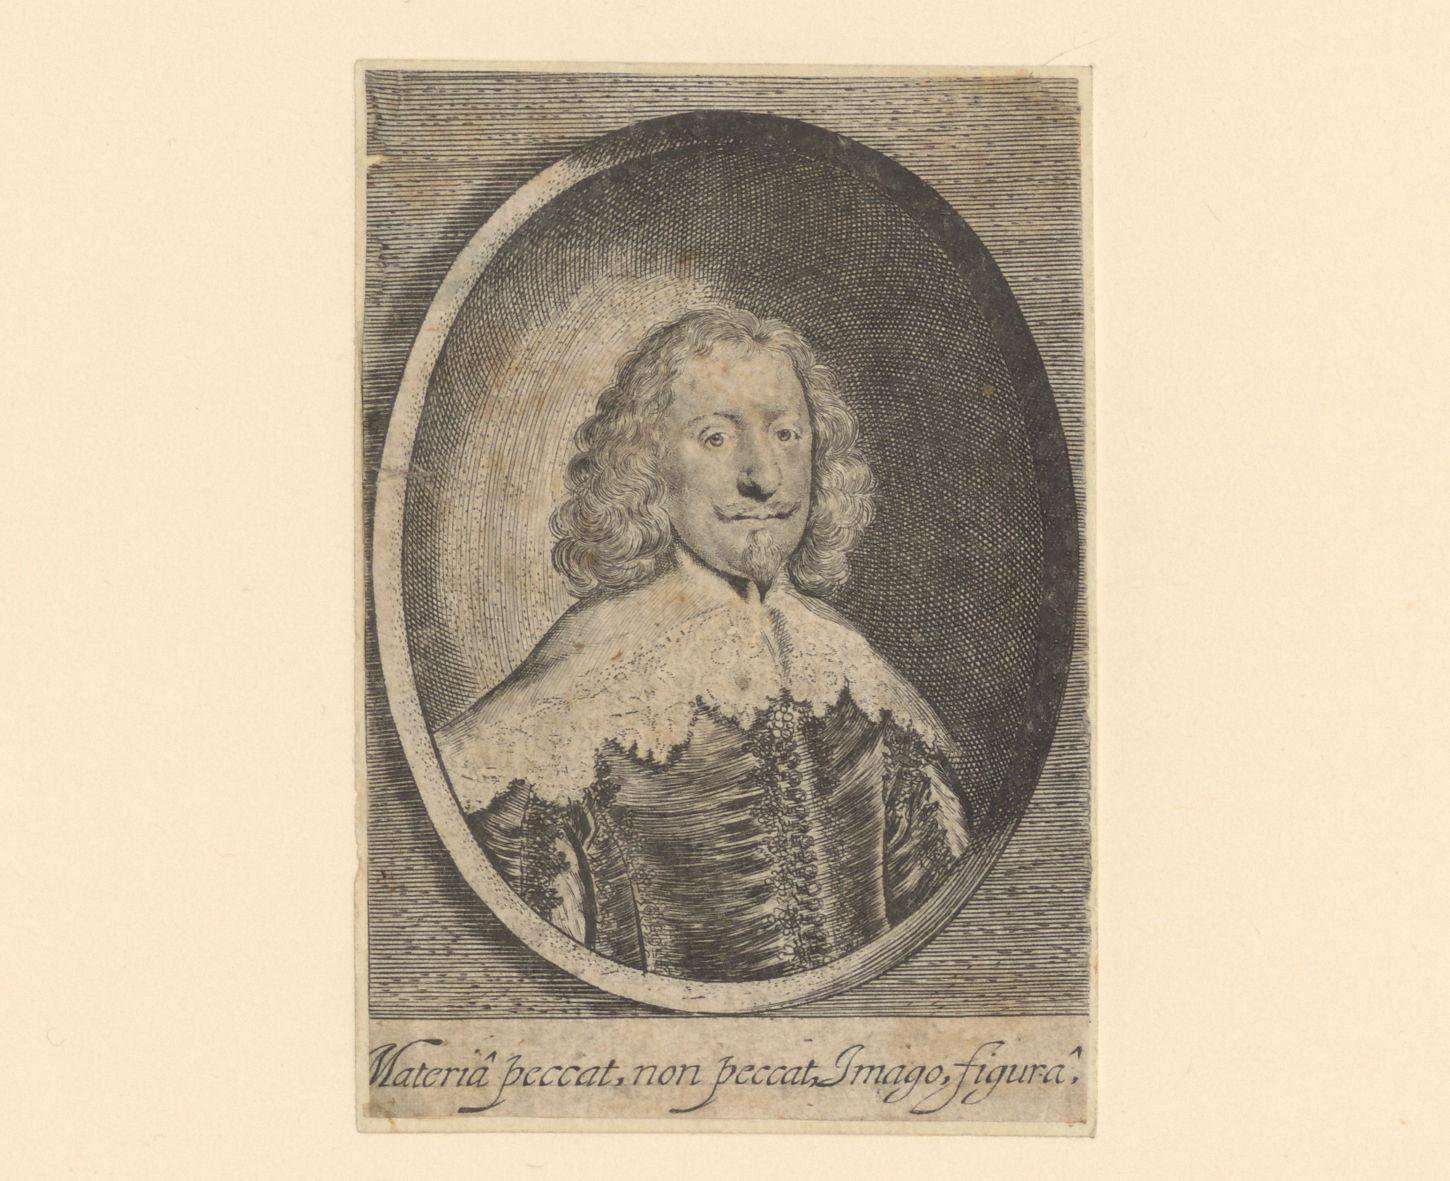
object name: print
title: Portret van William Hodson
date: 1636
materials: paper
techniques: engraving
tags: theologian, historical persons, portrait of a writer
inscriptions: collector's mark: Lugt 2228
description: Prent gebruikt in: Hodson, William. Credo Resurrectionem Carnis. Cambridge: Andrew Crooke, 1636.